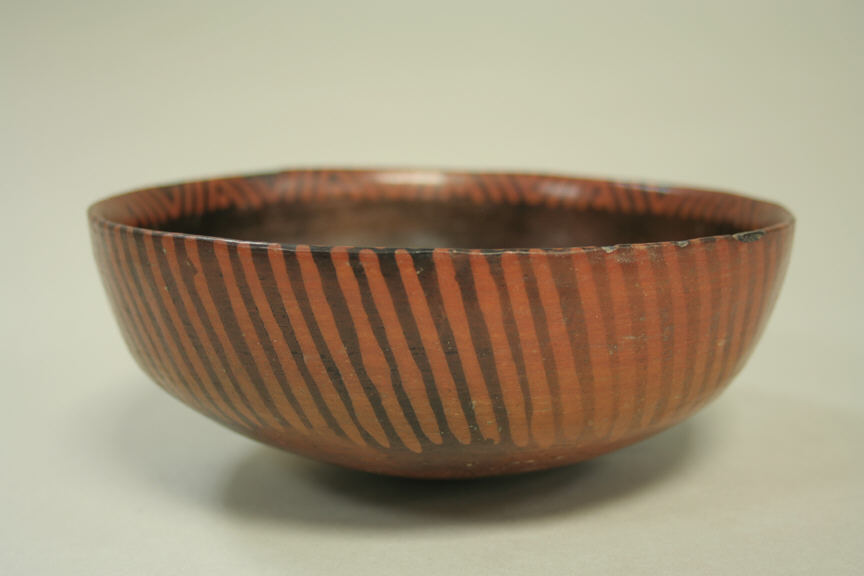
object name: bowl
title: Painted Bowl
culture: paracas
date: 700-201 BCE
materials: ceramic, pigment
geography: peru